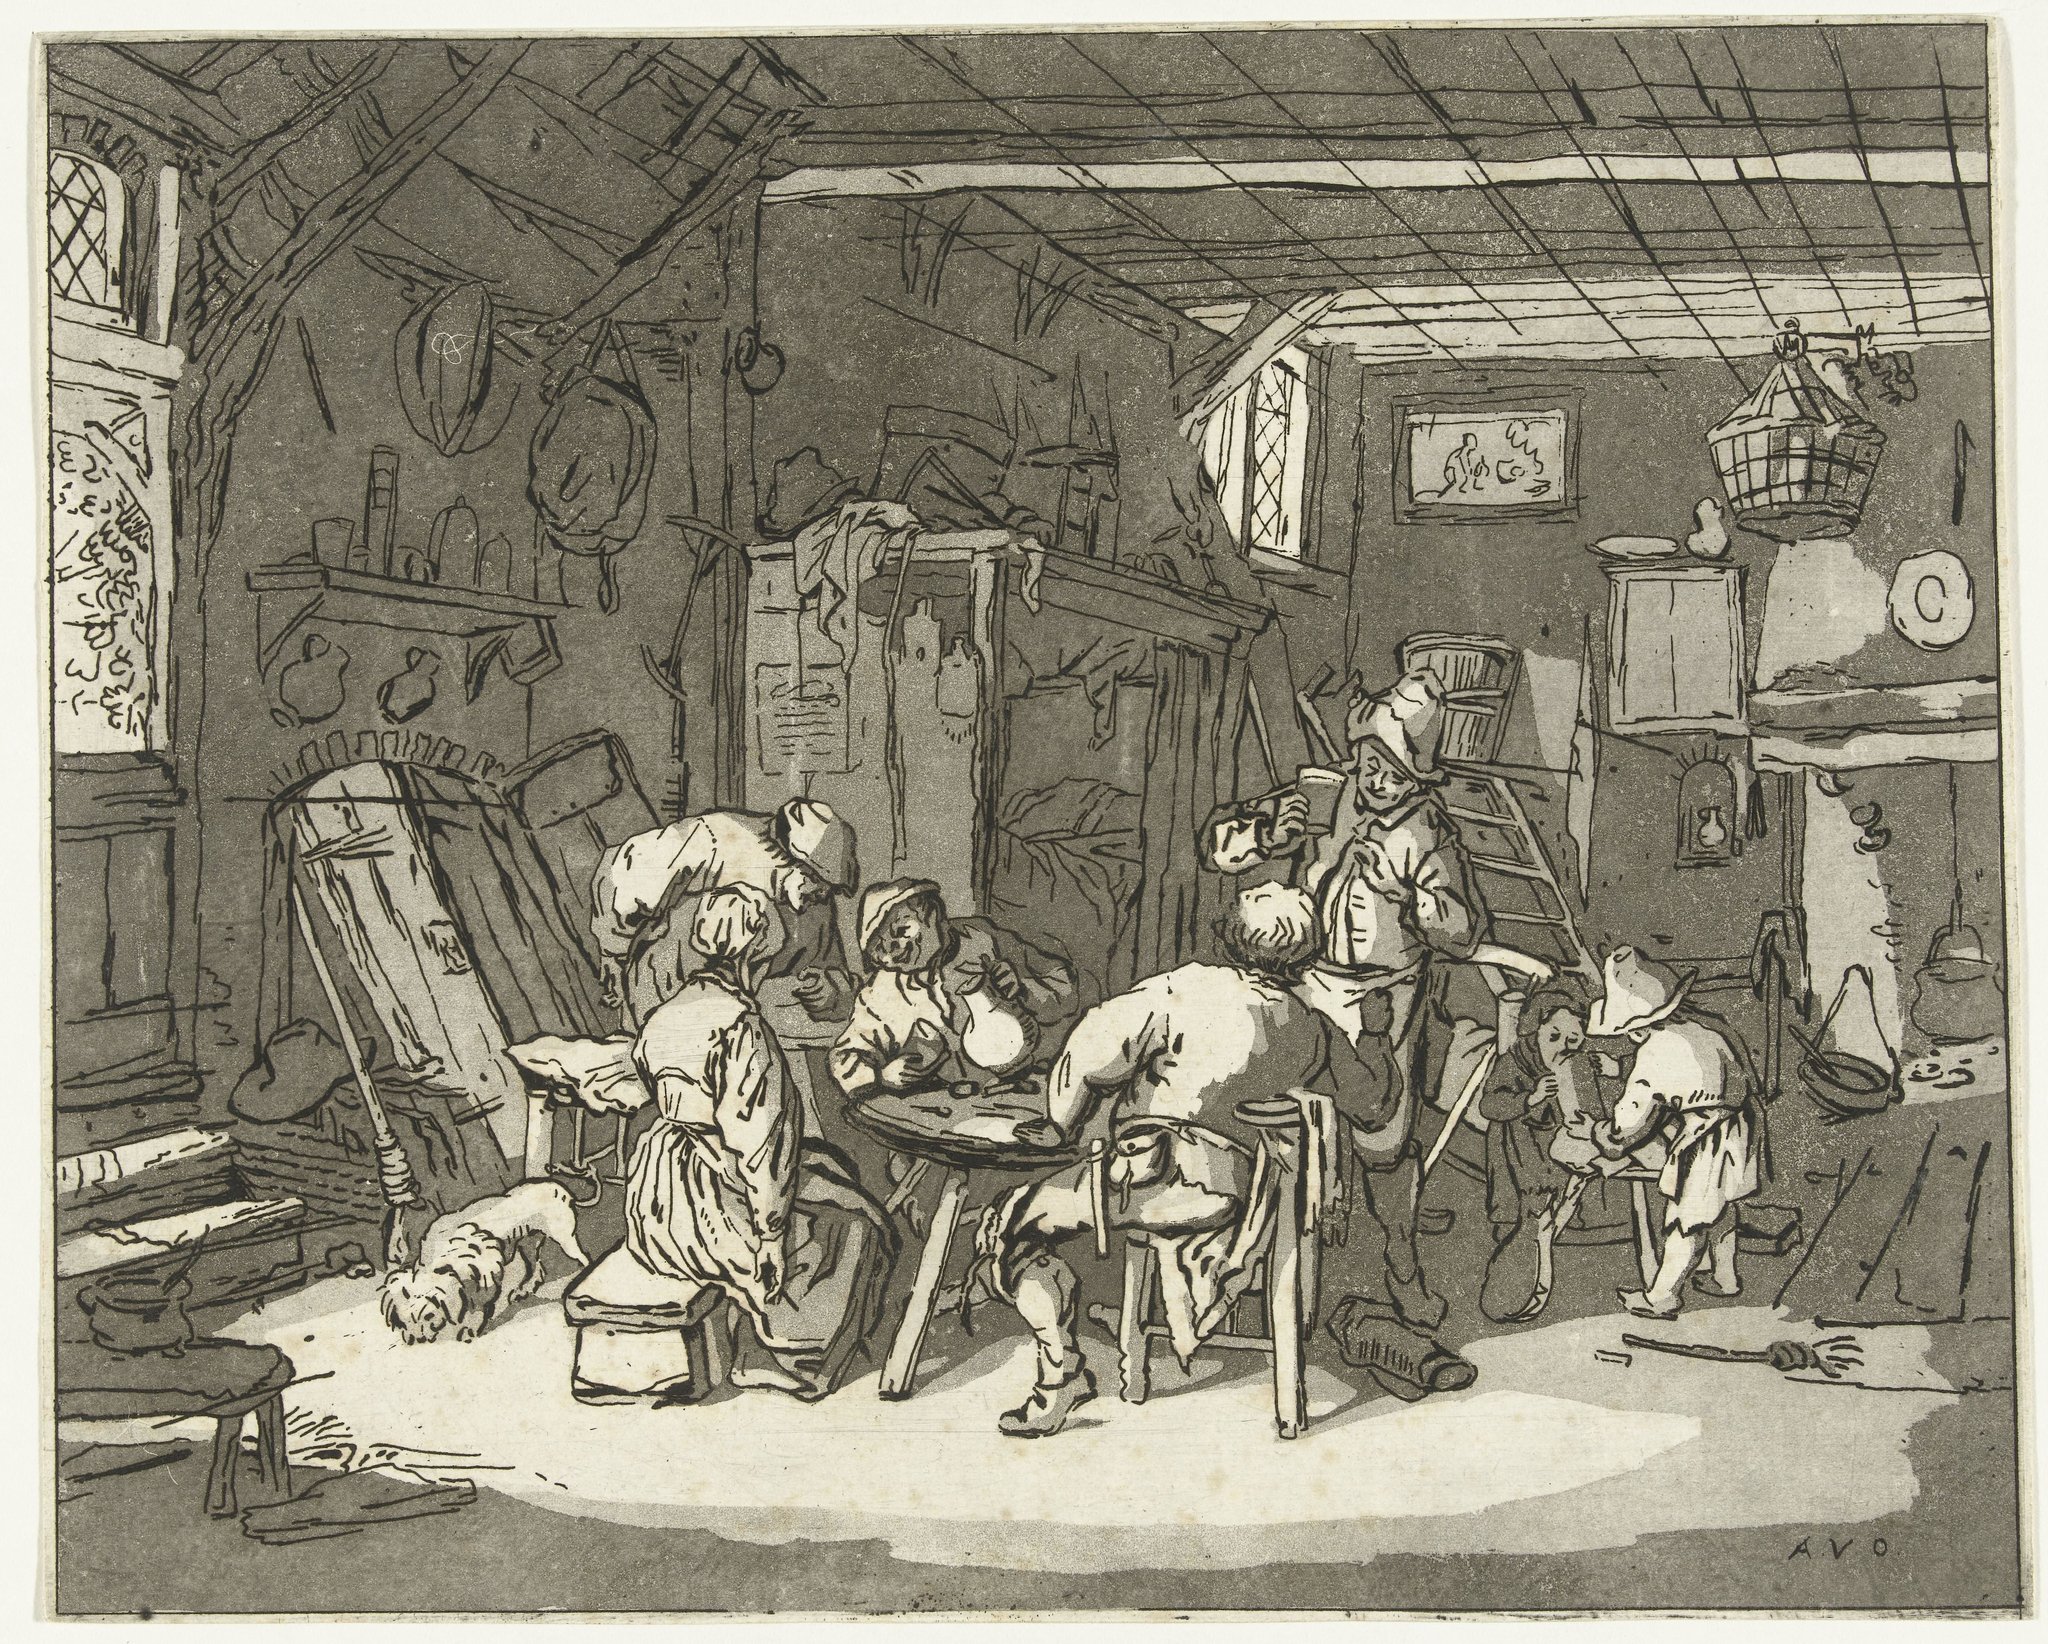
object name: print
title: Boereninterieur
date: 1778-1838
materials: paper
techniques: aquatint, etching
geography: netherlands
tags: farm (building) - aa - civic architecture: inside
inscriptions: collector's mark: Lugt 2228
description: Een groep boeren zit rond een tafel in een boerenkamer. De boeren drinken en zijn uitgelaten. Een jongen speelt met een klein meisje op de grond.